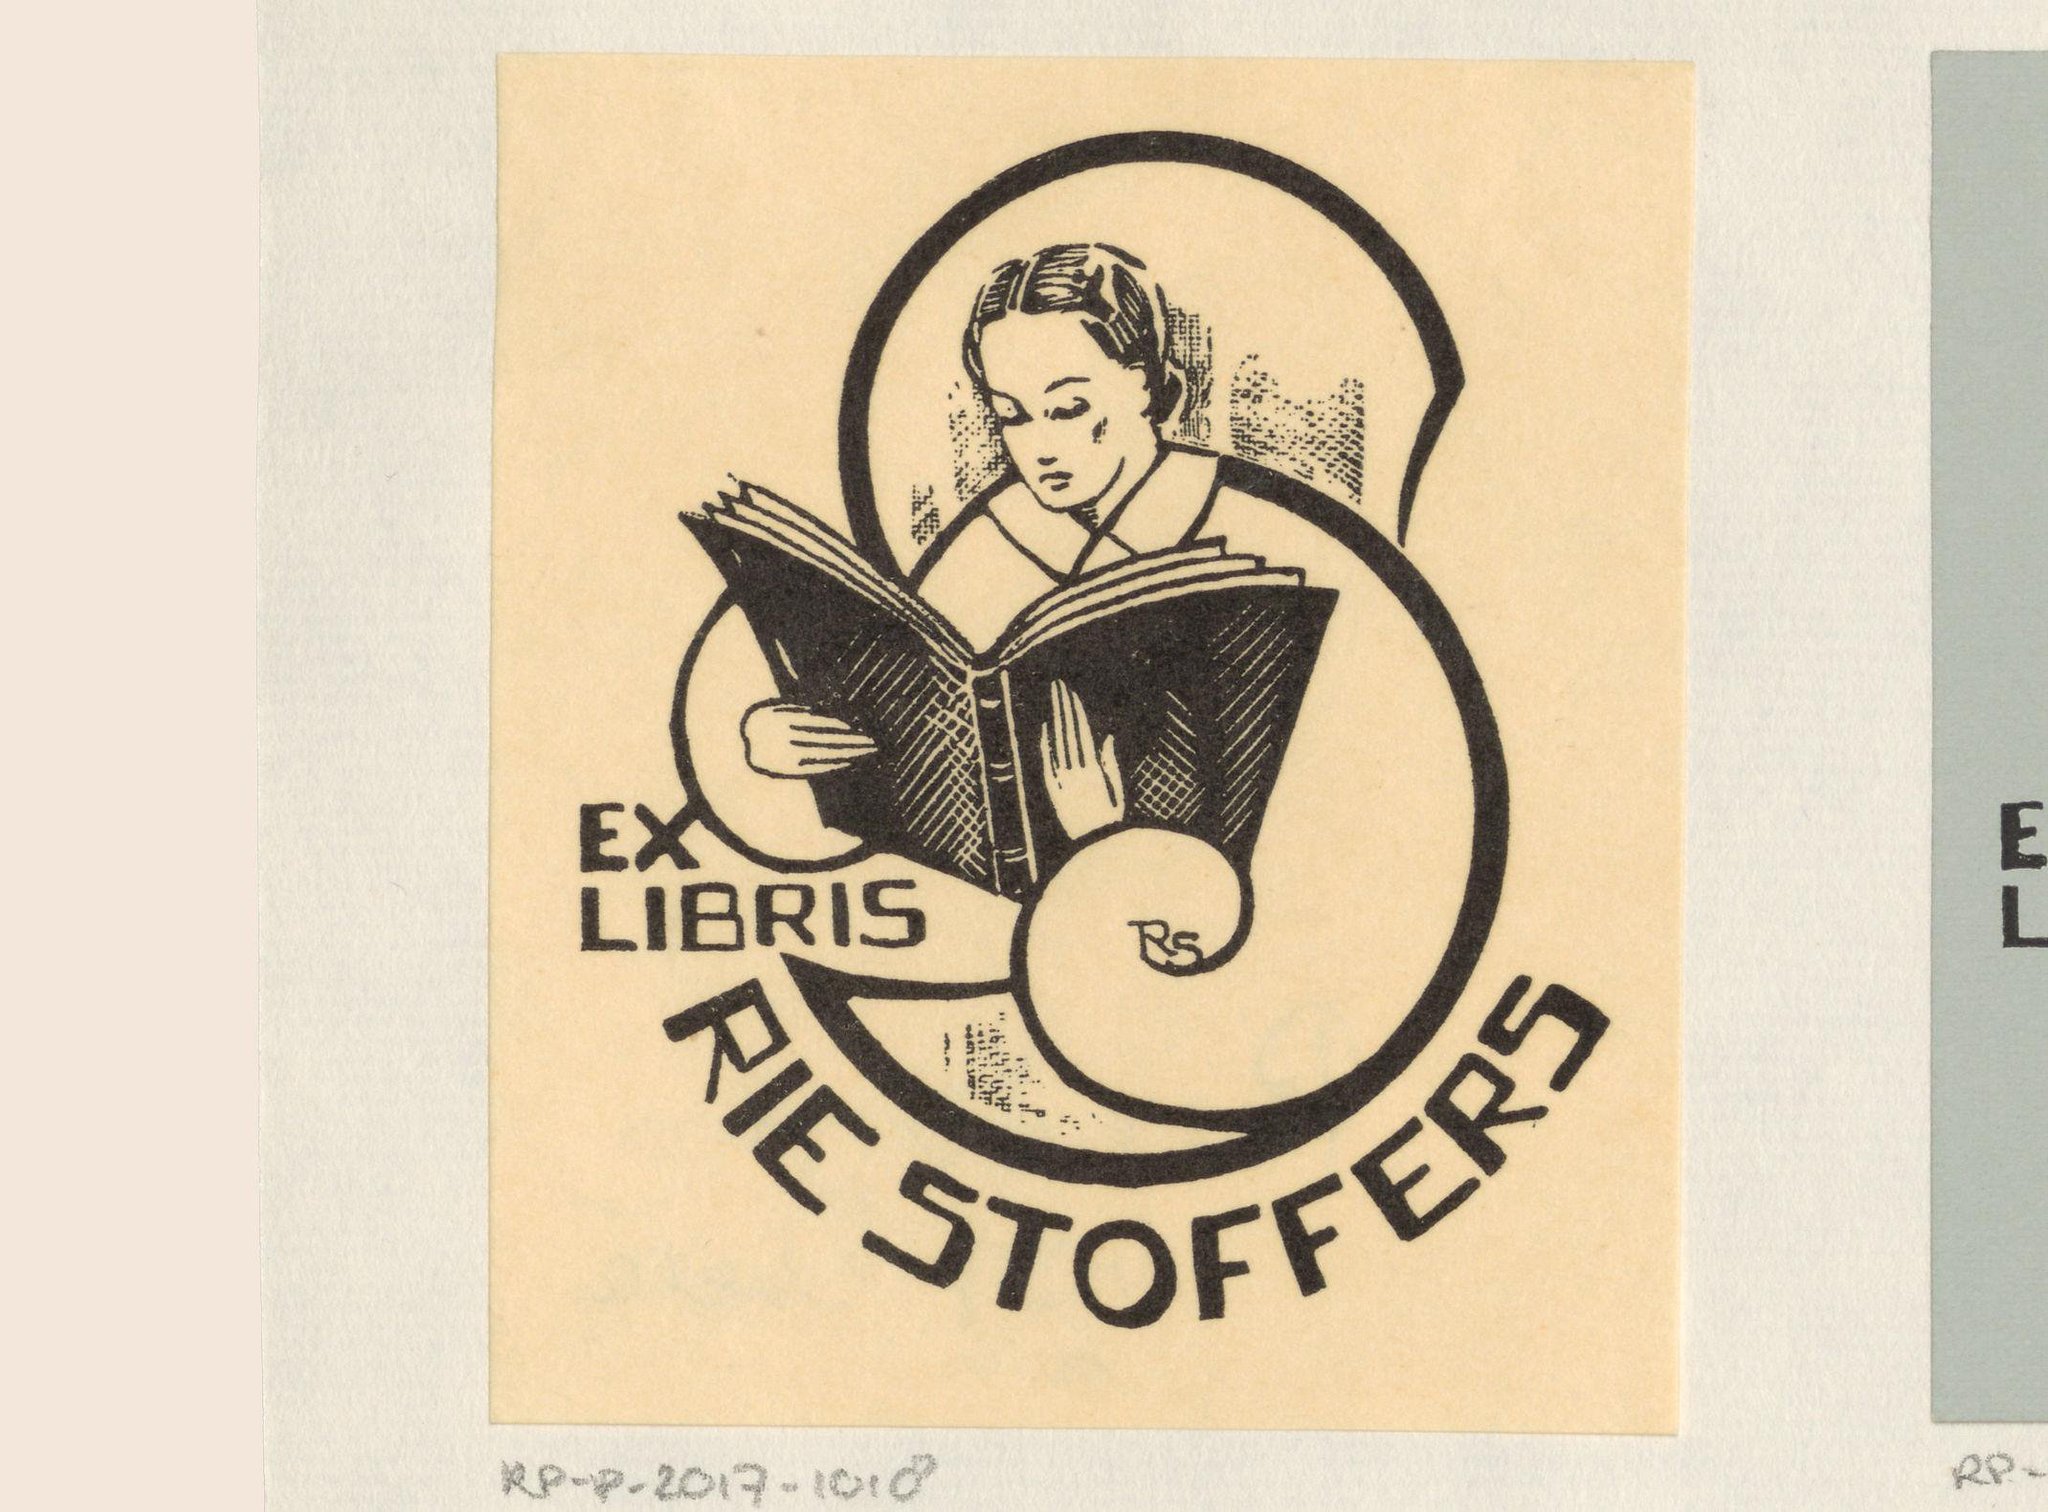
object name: bookplate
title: Ex libris van Rie Stoffers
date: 1937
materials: paper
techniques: printing block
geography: netherlands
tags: print maker, maria nunnikhoven-stoffers (rie), adult woman, reading, book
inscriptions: signature, date and inscription: ‘Rie Stoffers / 1937 Cliché’